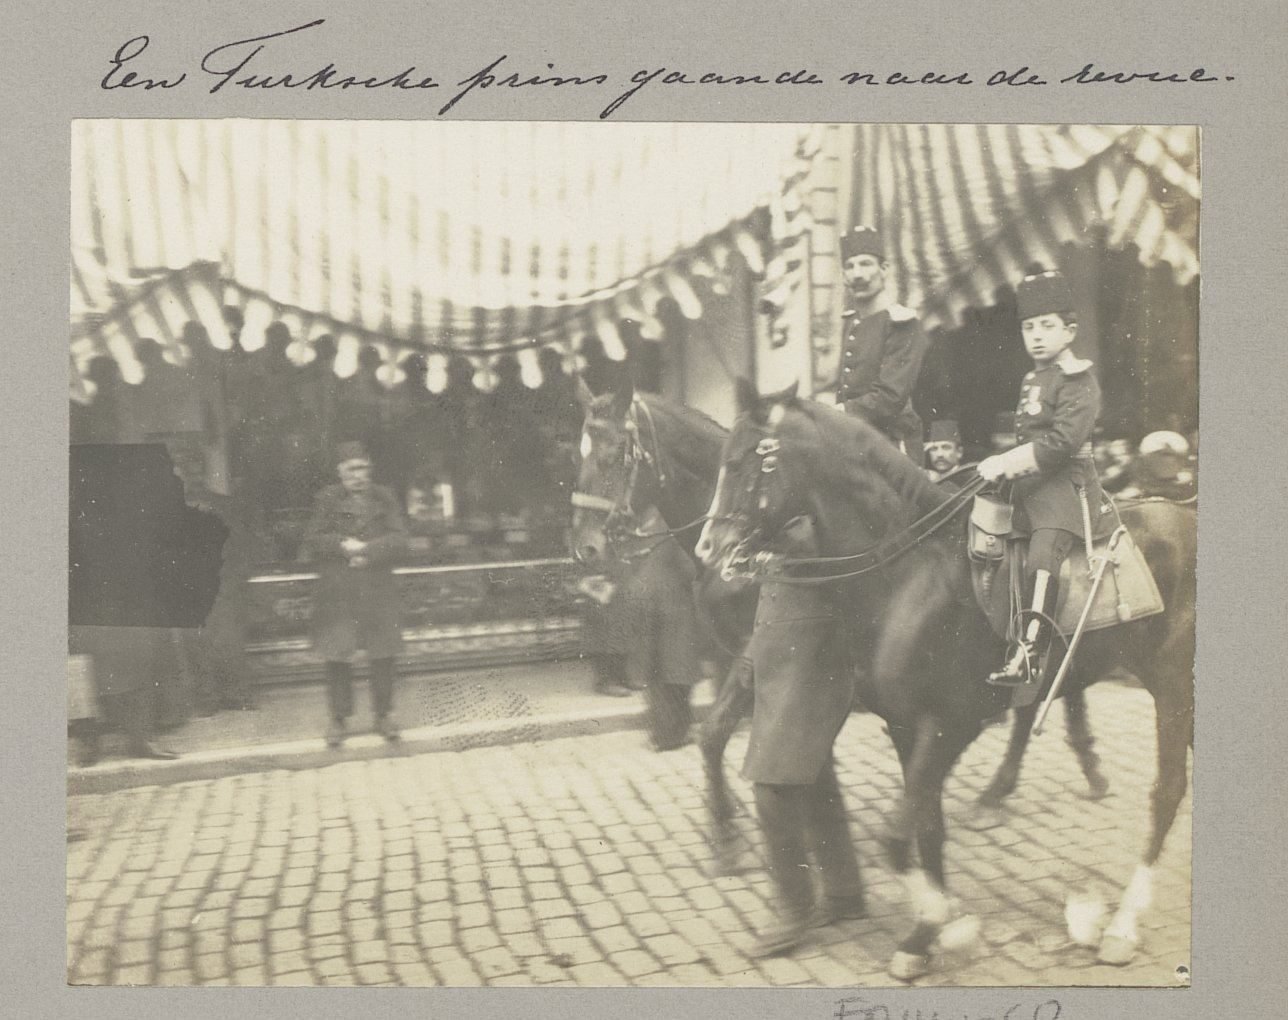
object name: photograph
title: Ottomaanse prins te paard op straat in Istanbul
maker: Anonymous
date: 1910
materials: photographic support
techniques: gelatin silver print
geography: istanbul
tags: riding a horse, ass, or mule; rider, horseman, child, military parade, pageant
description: Onderdeel van Fotoalbum van een reis door Zuid-Europa en het Midden-Oosten.